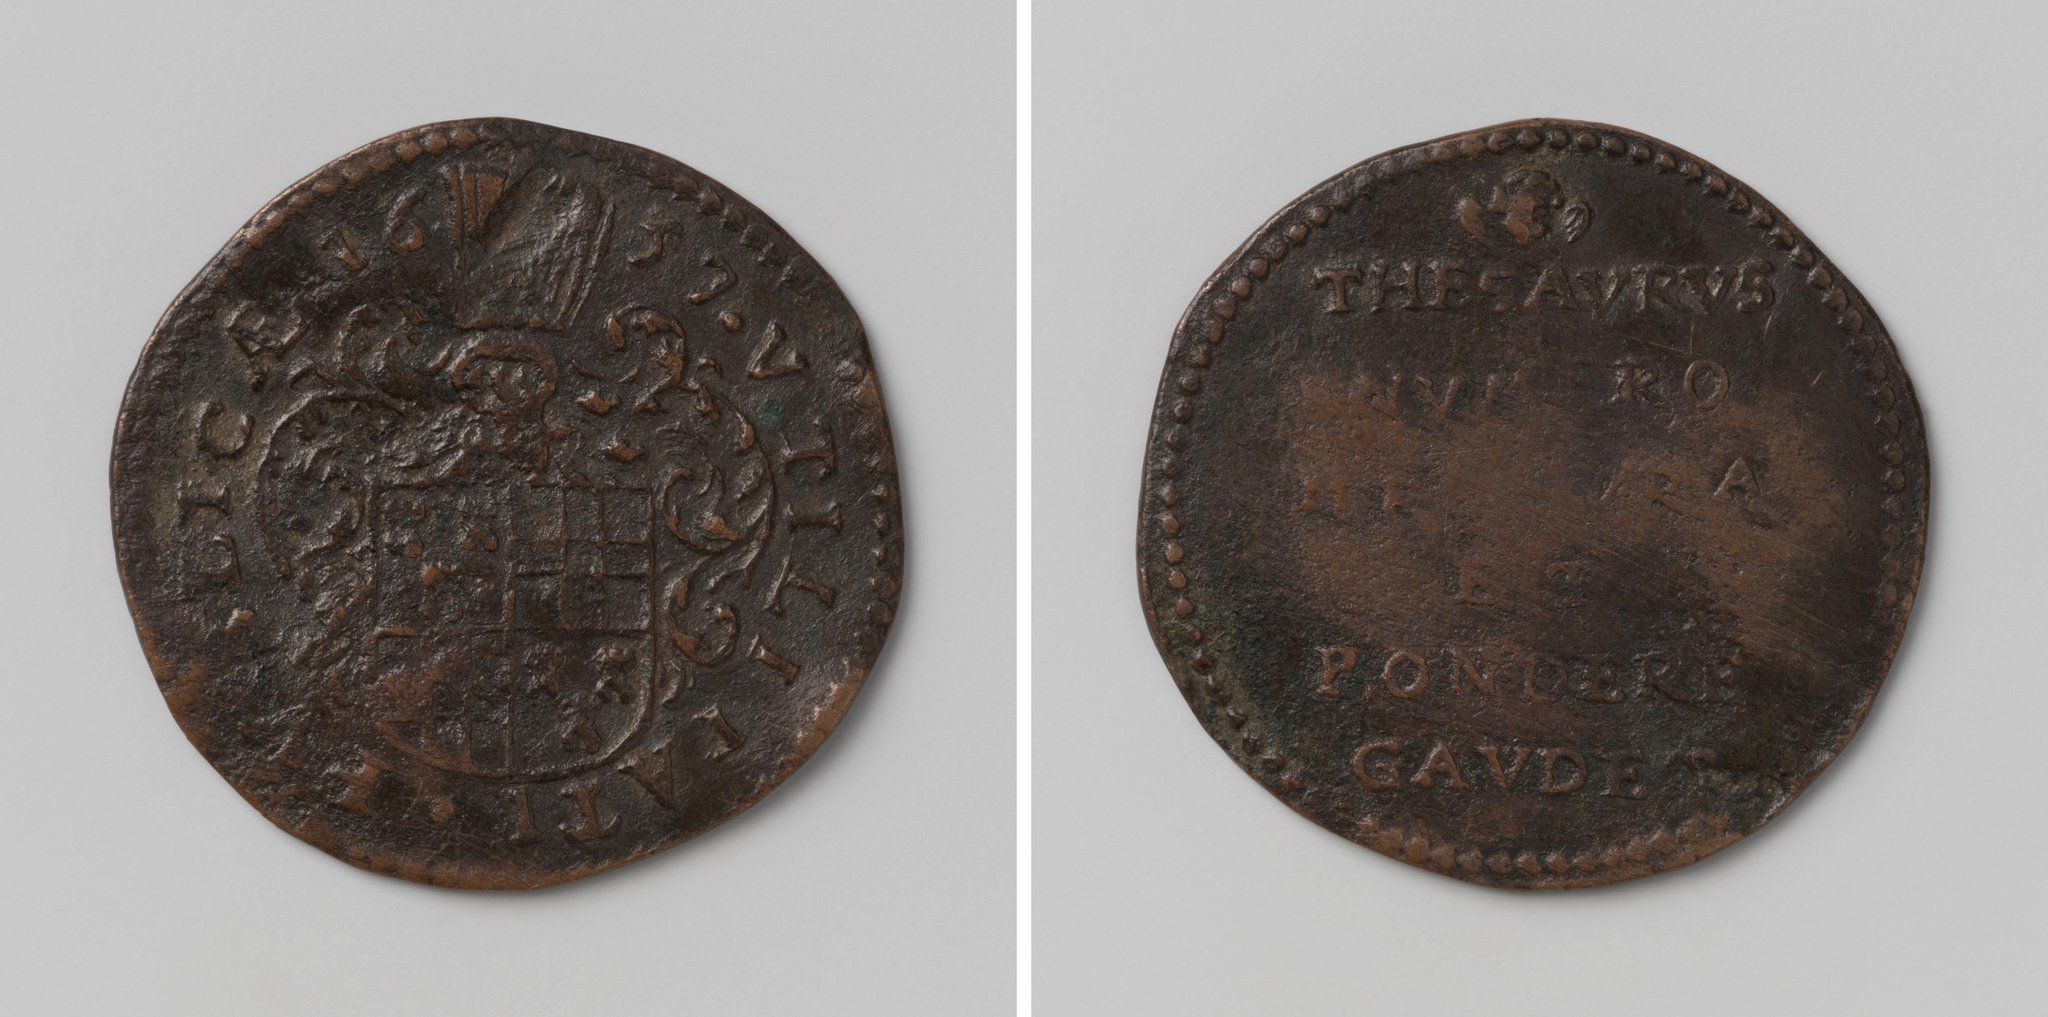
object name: jeton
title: Jean van den Hecke, magistraat van de schatkist van Brussel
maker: Anonymous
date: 1601-1657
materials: copper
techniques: striking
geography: brussels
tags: brussels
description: Koperen penning. Voorzijde: gehelmd wapenschild binnen omschrift. Keerzijde: opschrift